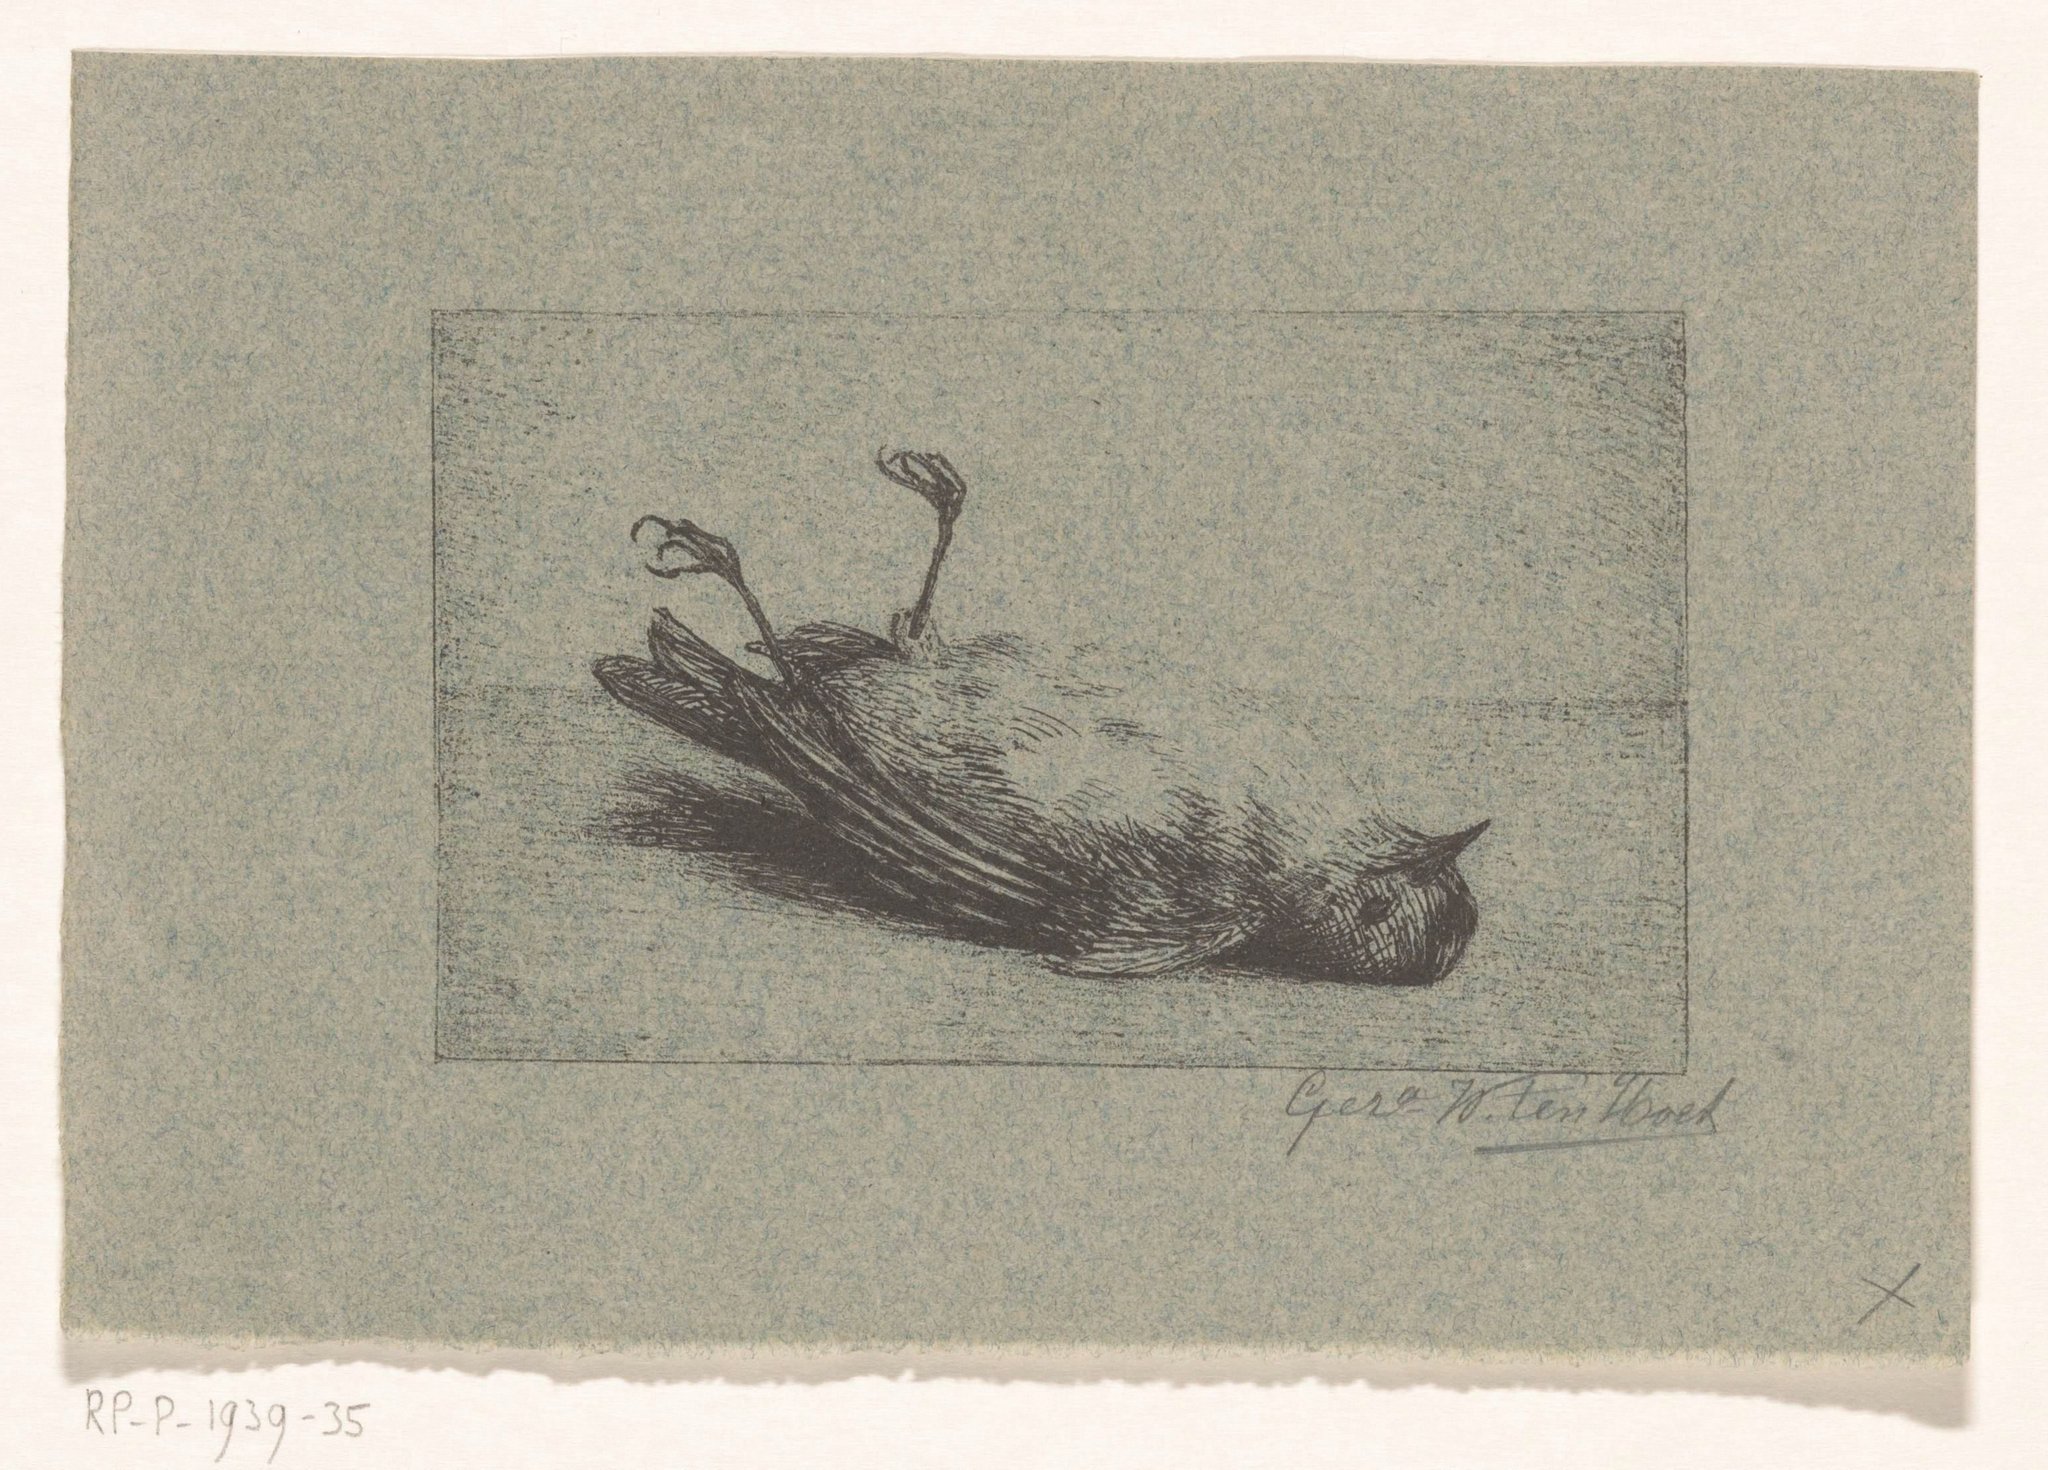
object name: print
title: Dode vogel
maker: gerarda wilhelmina ten hoet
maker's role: print maker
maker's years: 1857-1939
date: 1867-1939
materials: paper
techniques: lithograph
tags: birds (+ dying animal; death of animal; dead animal)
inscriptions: collector's mark: Lugt 2228